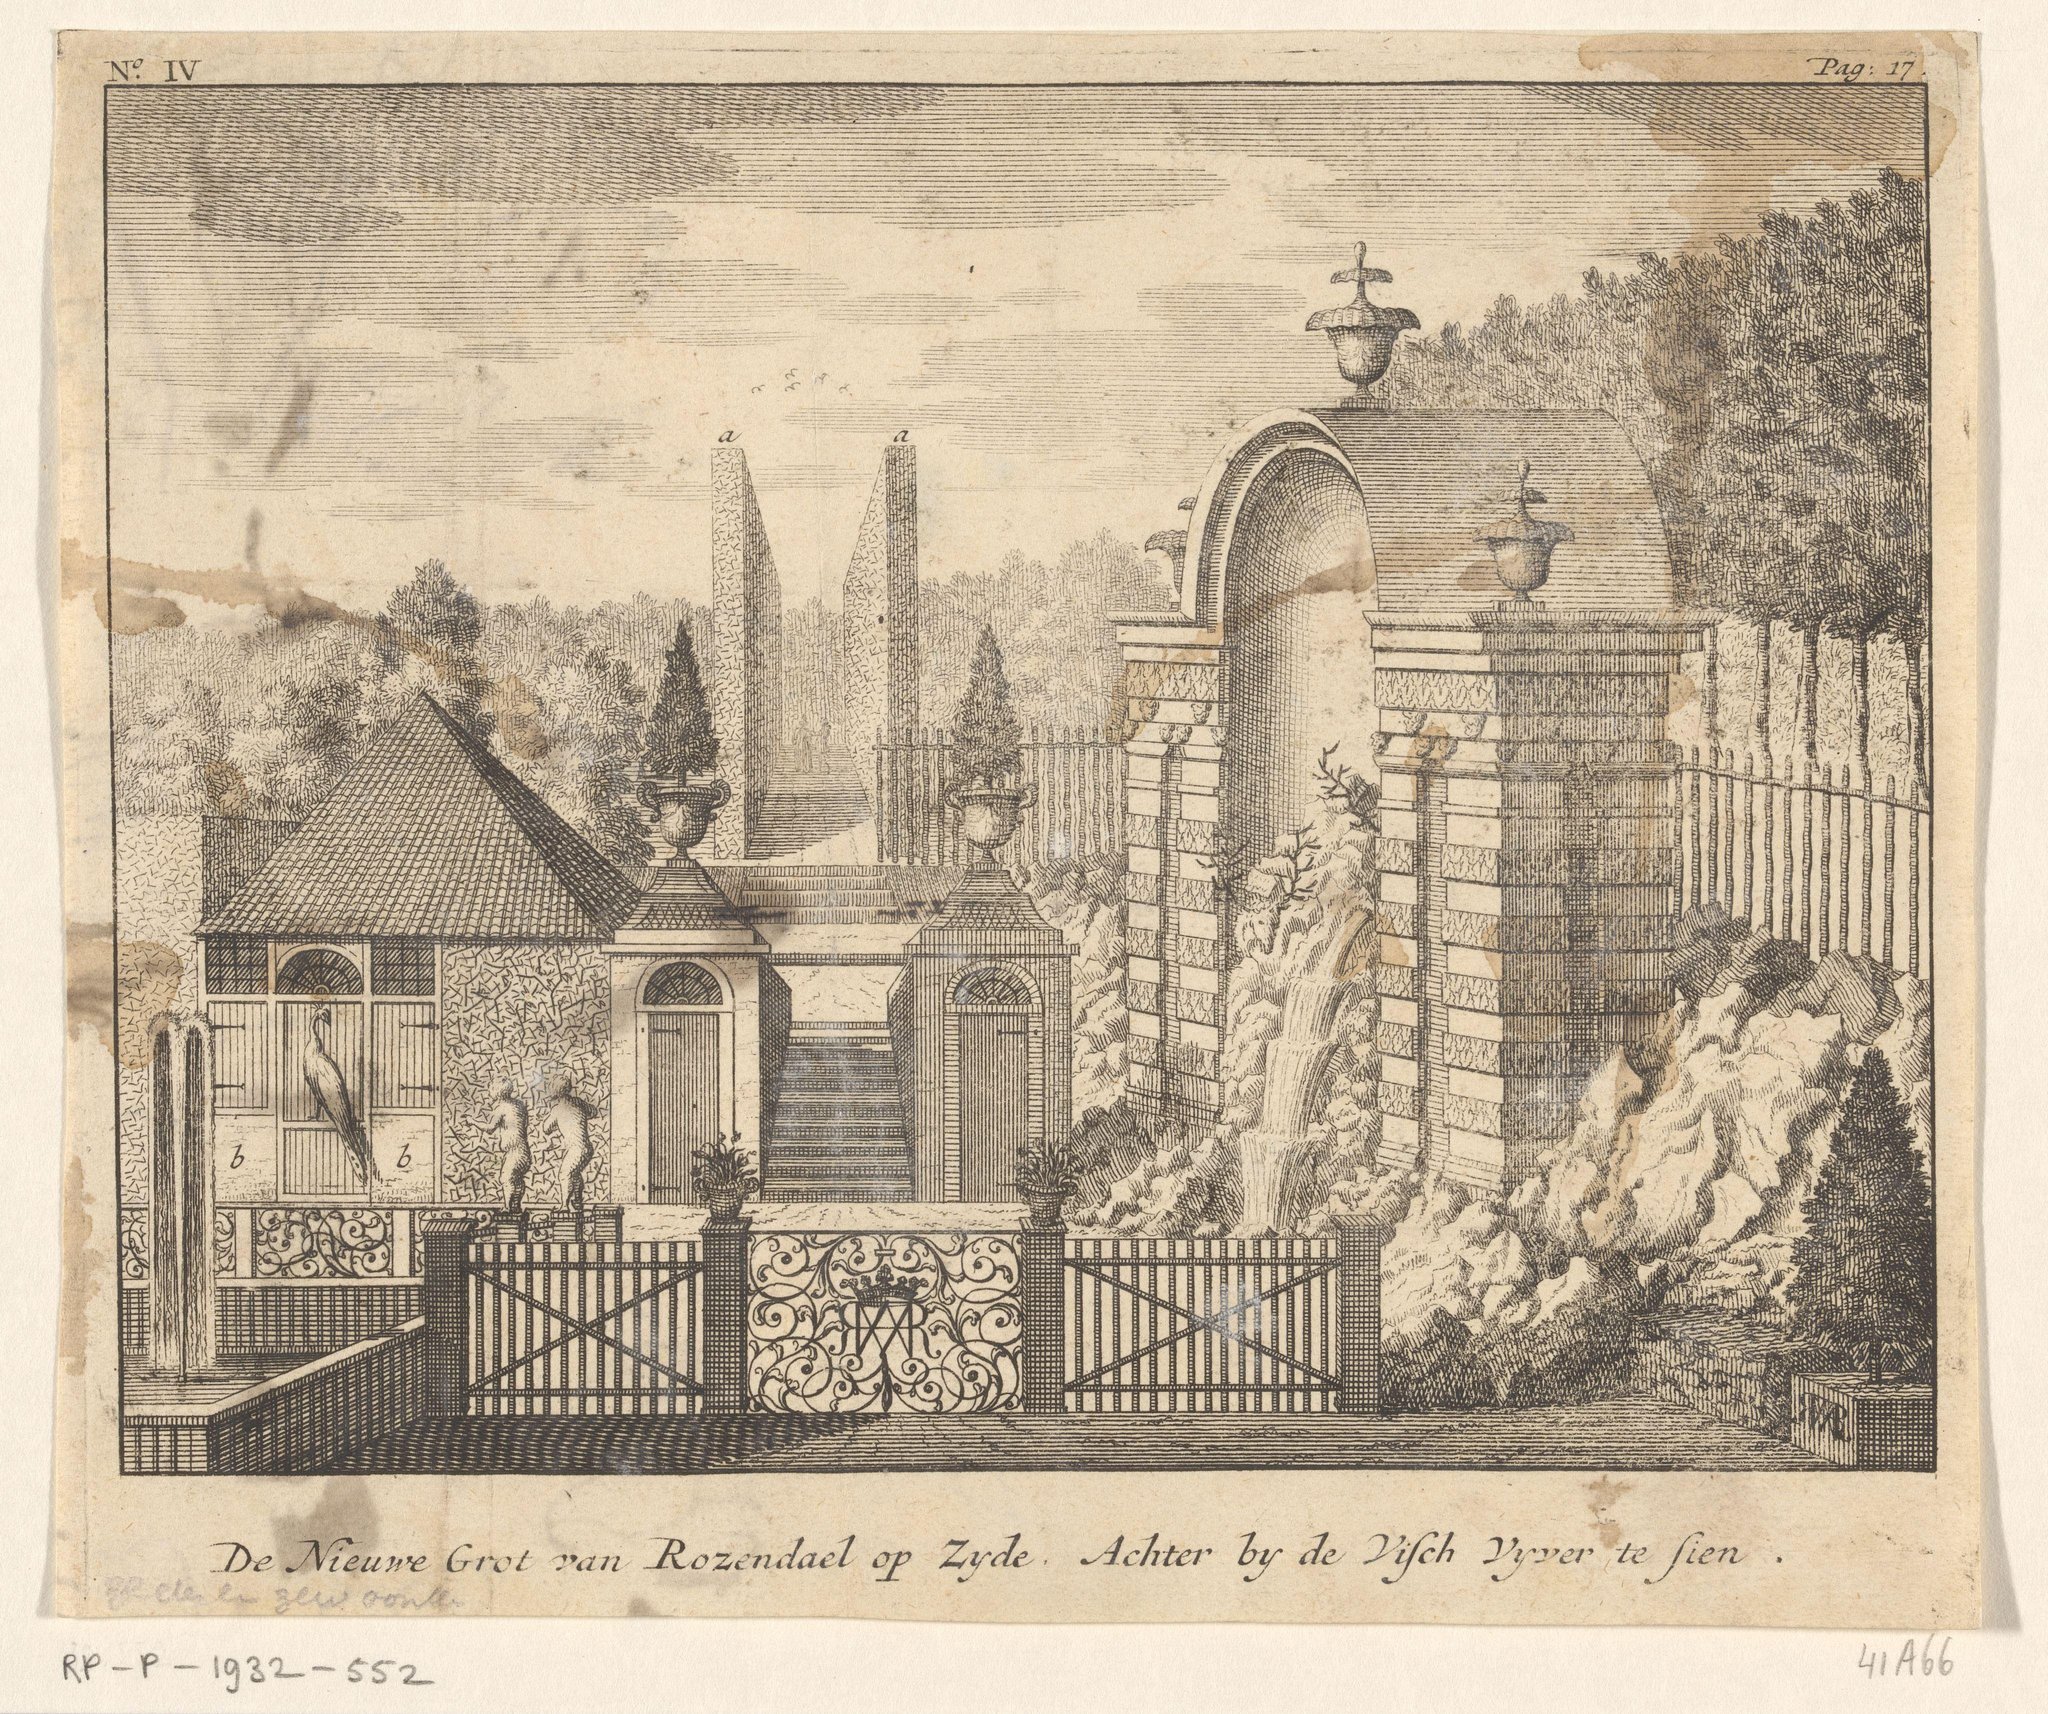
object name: print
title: De Nieuwe Grot van Rozendael op zijde. Achter bij de Visch Vijver te sien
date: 1718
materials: paper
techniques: etching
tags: artificial grotto in garden, cave, grotto, ornamental fountain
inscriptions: collector's mark: Lugt 2233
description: Betreft een variant op een prent uit een serie, uitgegeven door Pieter I Schenck (zie RP-P-1911-3475).